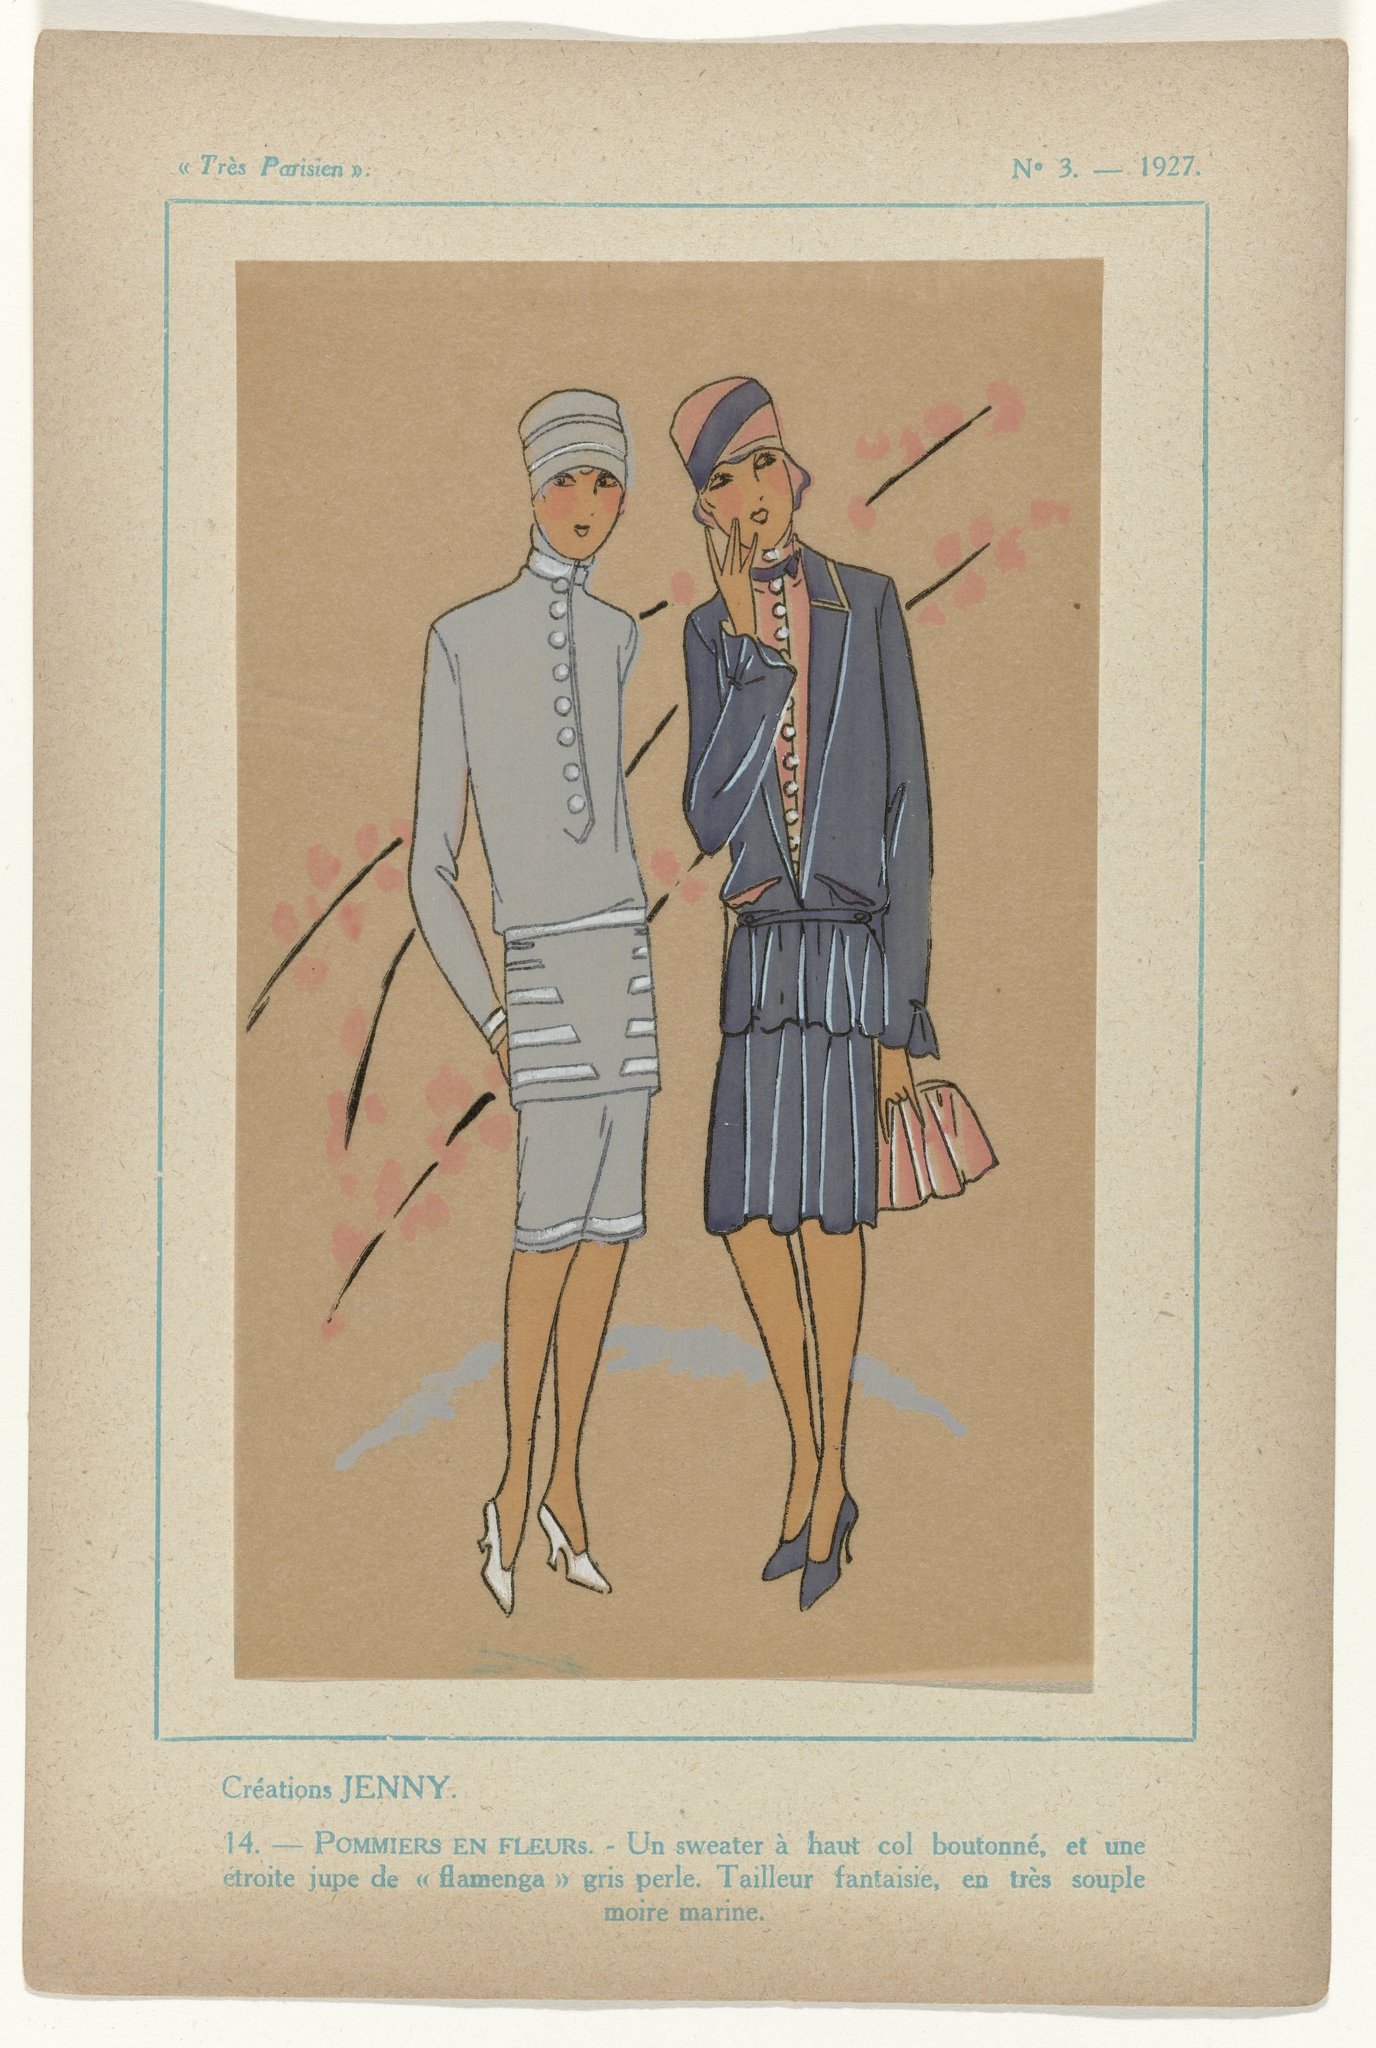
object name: fashion print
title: Très Parisien, 1927 No. 3, Pl. 4: Créations JENNY - POMMIERS ET FLEURS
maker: g-p. joumard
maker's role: publisher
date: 1927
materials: paper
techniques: hand coloring, letterpress printing, lithography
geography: paris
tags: clothing for the upper part of the body (sweater) (+ women's clothes), ensembles of pieces of clothing (tailleur) (+ women's clothes), fashion plates, skirt (+ women's clothes)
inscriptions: caption: ‘POMMIERS EN FLEURS. - Un sweater à haut boutonné, et une étroite jupe de "flamenga" gris perle. Tailleur fantaisie, en très souple moire marine.’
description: Grijs ensemble van sweater met hoge kraag en strakke rok; tailleur in marineblauw, van modehuis Jenny. Prent uit het modetijdschrift Très Parisien...La Mode, Le Chic, L'Élégance (1920-1936)